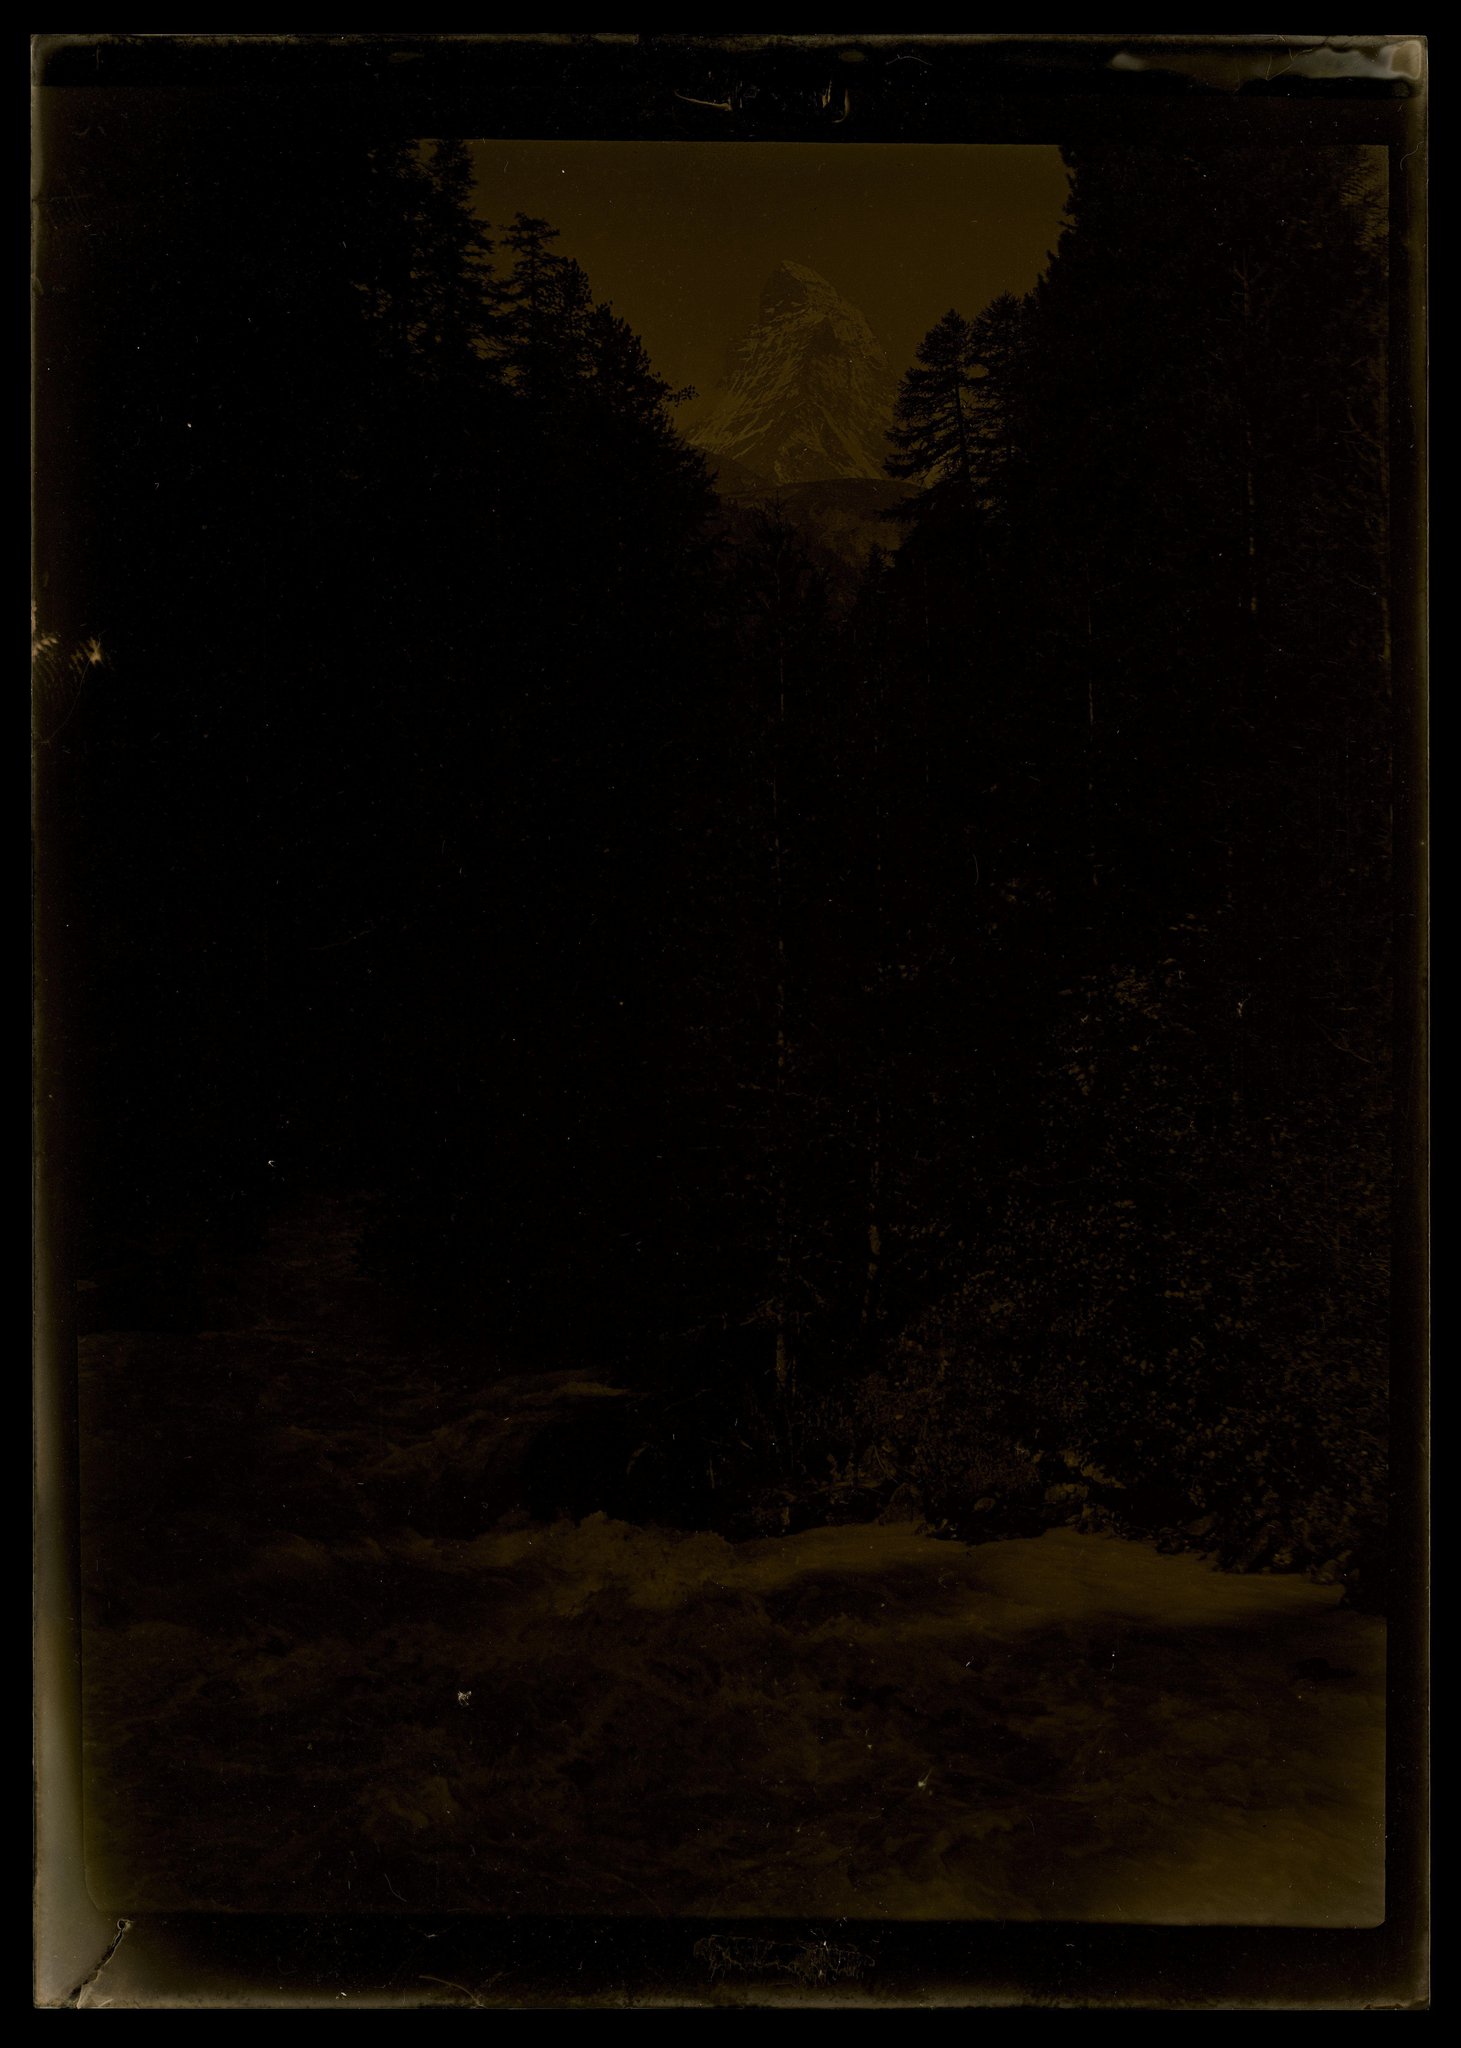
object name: photograph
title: Filmnegatief met opname van Zermatt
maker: Anonymous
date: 1921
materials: film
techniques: gelatin silver negative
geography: zermatt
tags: zermatt